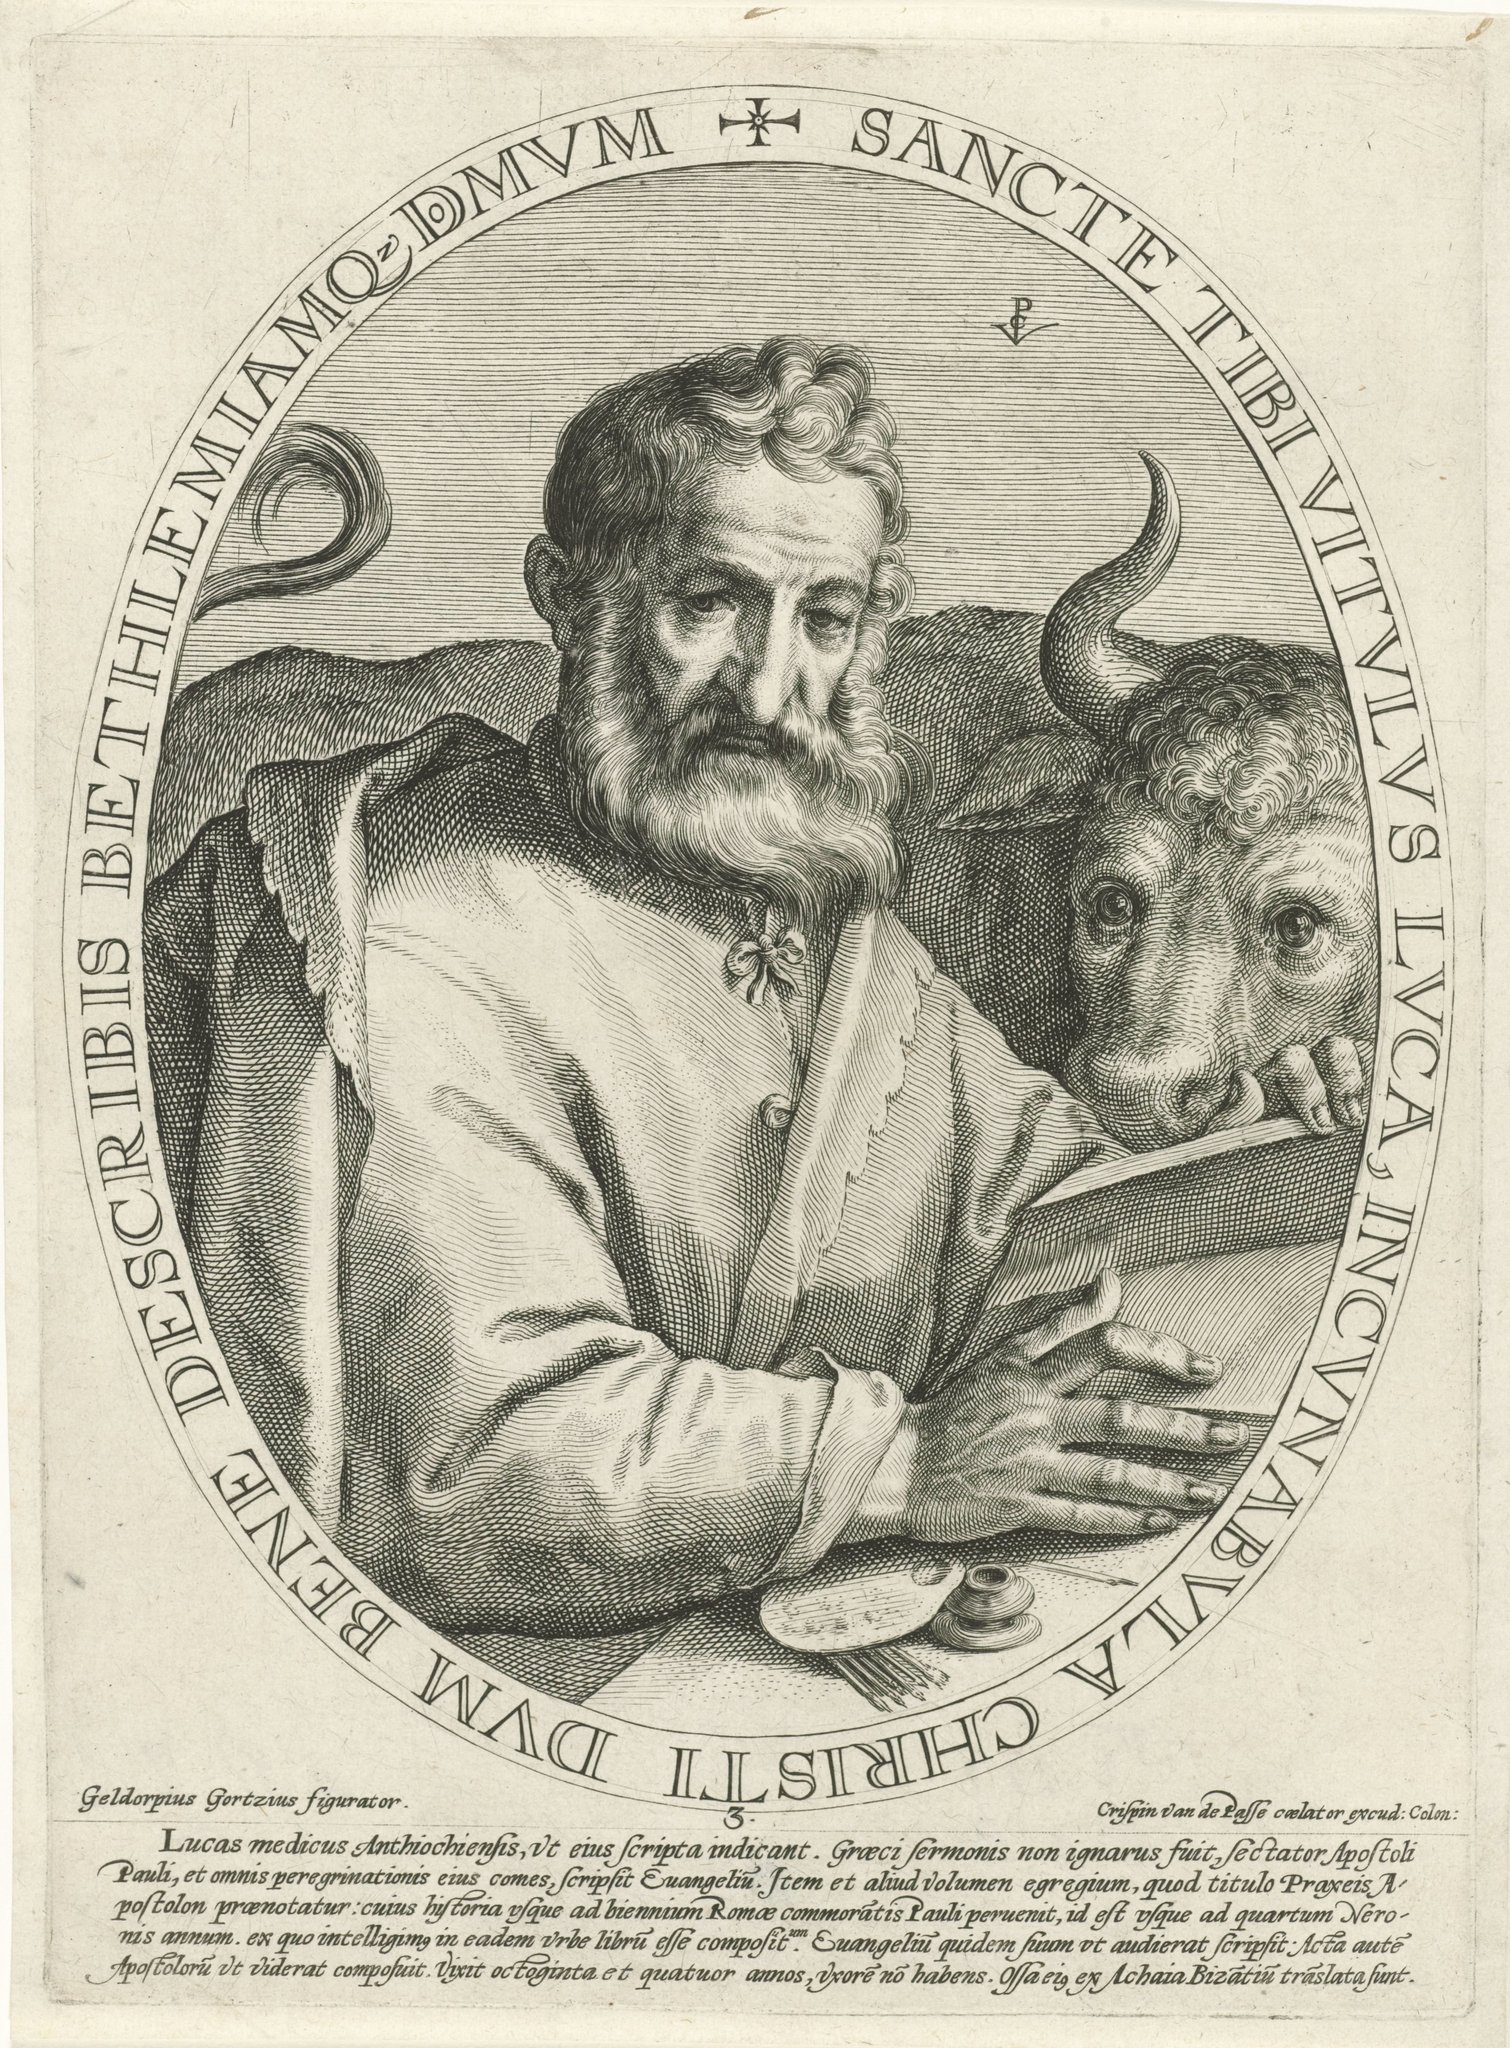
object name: print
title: De vier evangelisten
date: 1574-1637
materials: paper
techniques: engraving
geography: cologne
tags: luke the evangelist; possible attributes: book, (winged) ox, portrait of the virgin, surgical instruments, painter's utensils, scroll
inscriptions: collector's mark: Lugt 2228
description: Buste van de evangelist Lucas die met zijn schilderattributen aan een tafel zit. Achter hem zijn attribuut de os. De voorstelling is gevat in een ovale omlijsting met een randschrift in het Latijn. In de marge een vijfregelig onderschrift in het Latijn. Derde prent uit een serie van vier met de evangelisten.